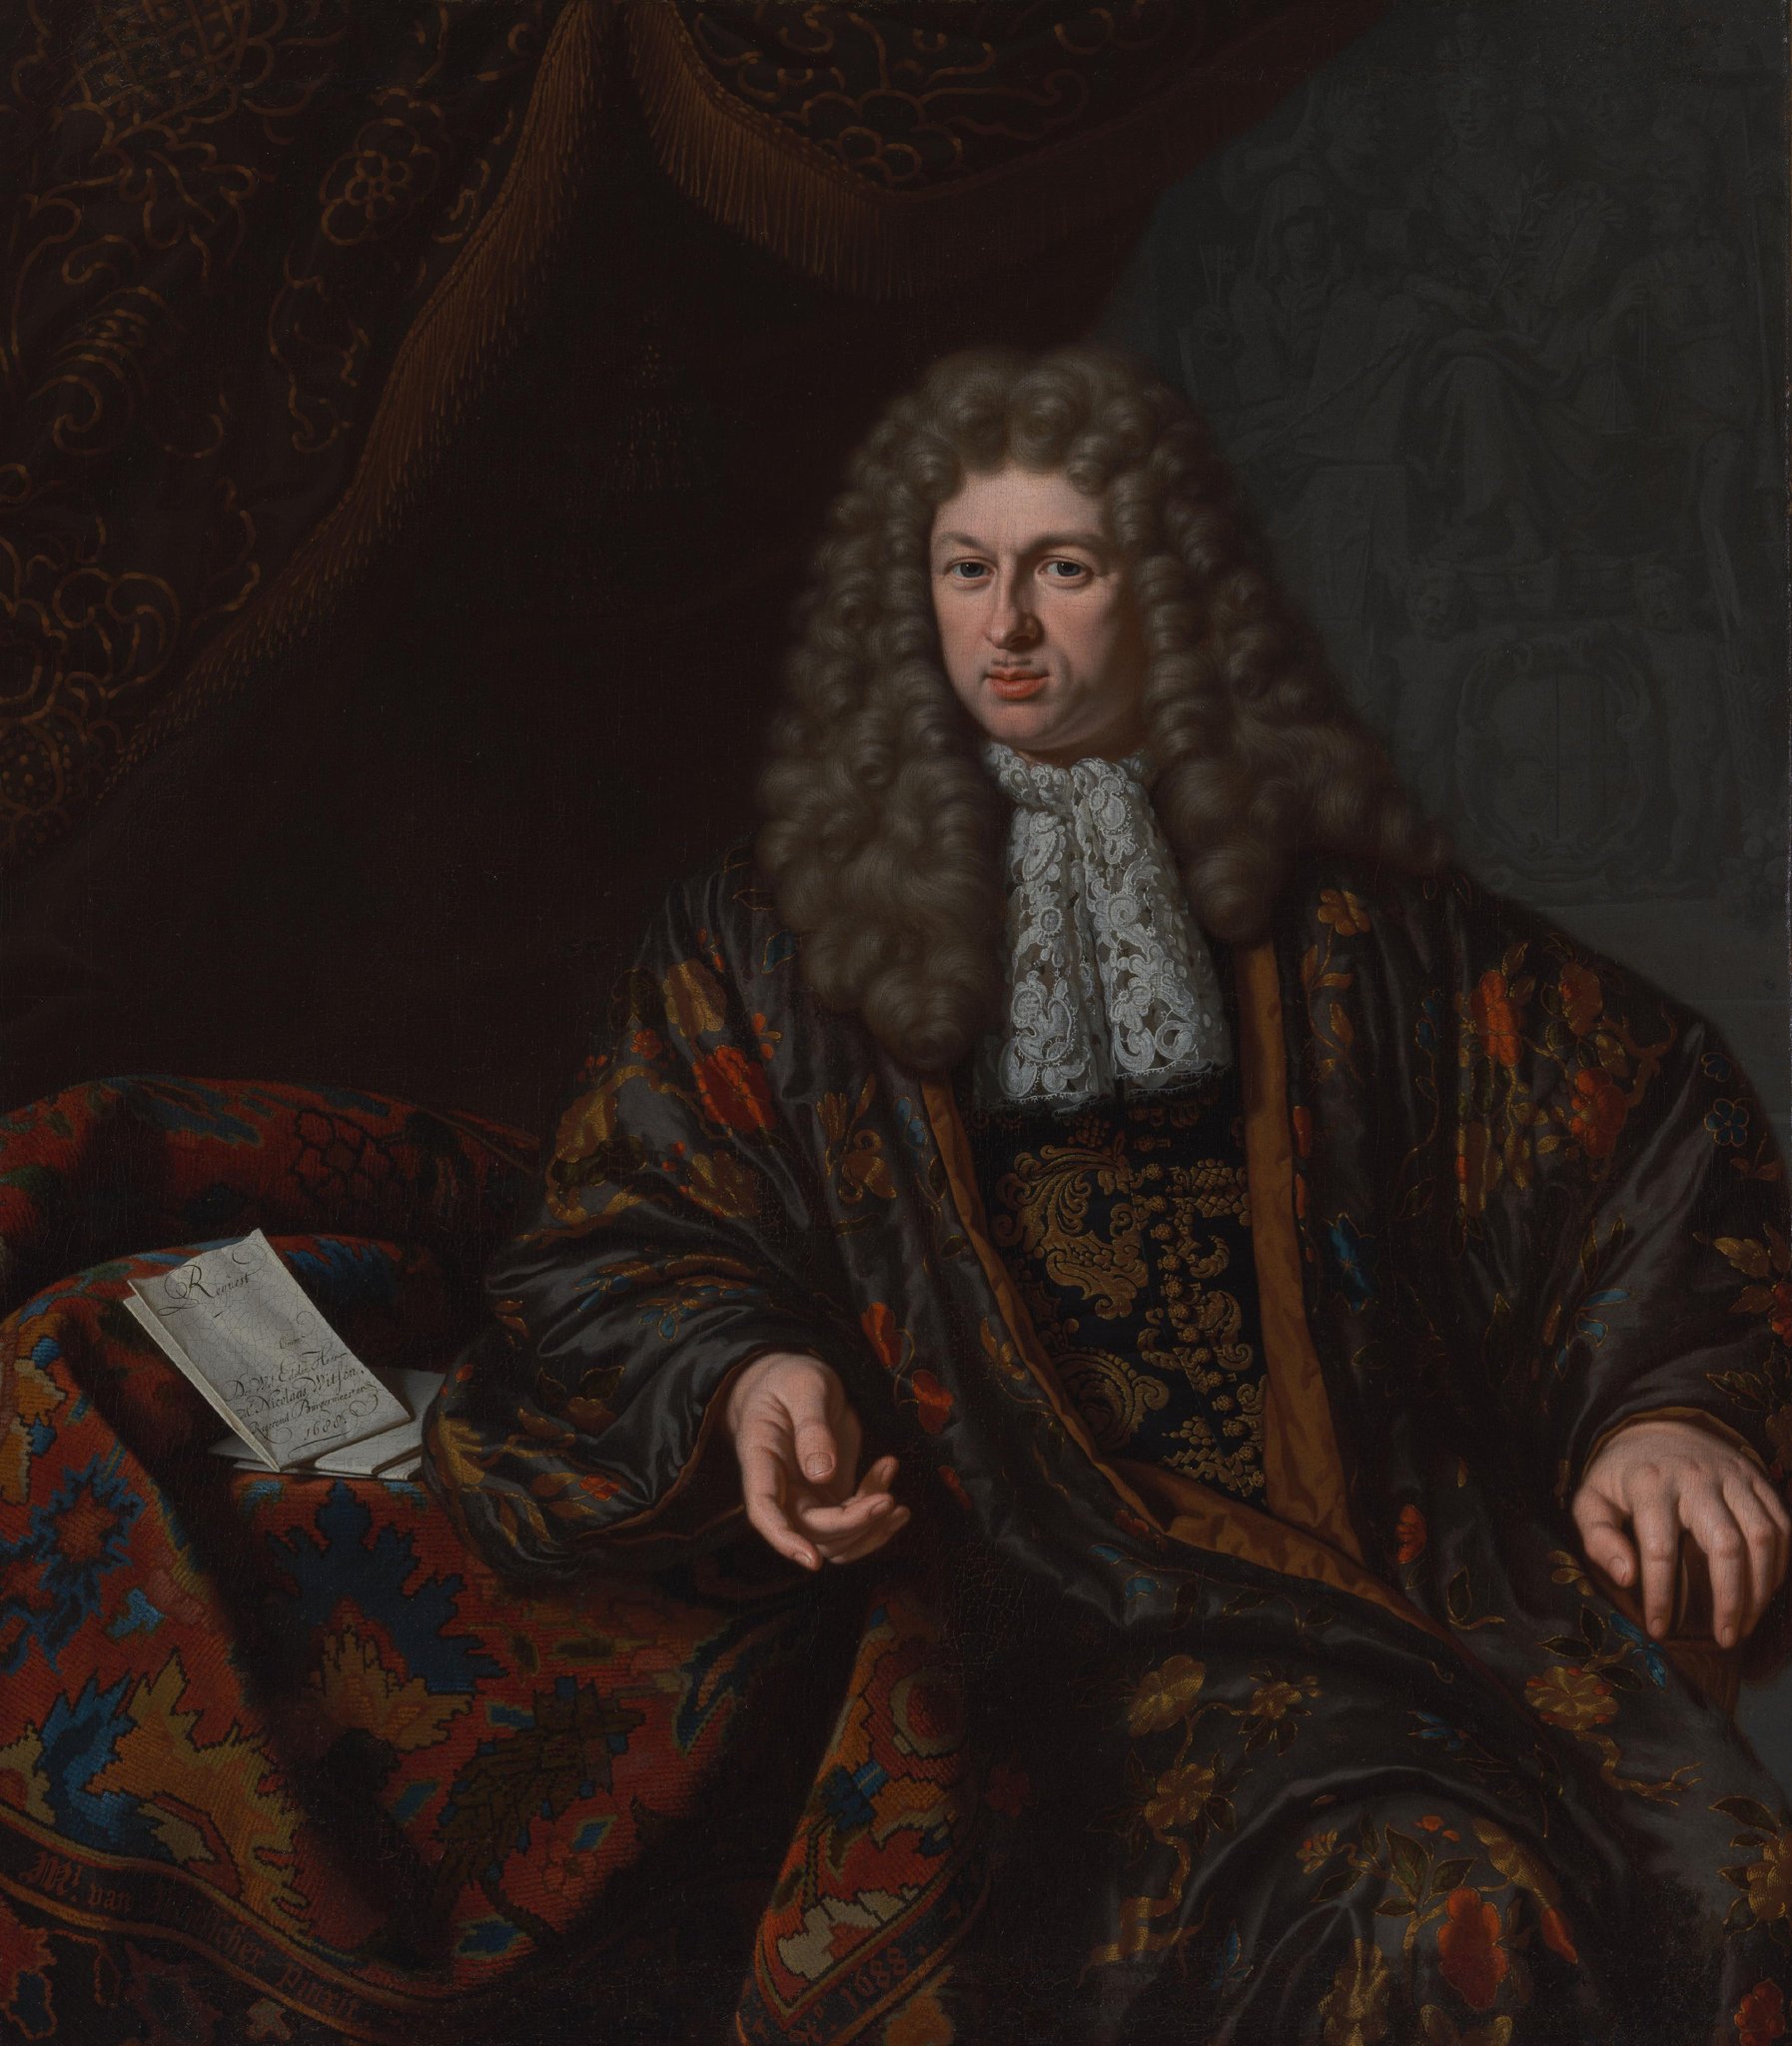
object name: painting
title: Portret van Nicolaes Witsen (1641-1717)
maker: michiel van musscher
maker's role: draughtsman, painter, print maker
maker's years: 1645-1705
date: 1688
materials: canvas, oil, paint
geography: amsterdam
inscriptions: inscription: ‘Request / Ommen / Den Wel Edelen Heer / Mr. Nicolaas Witsen, / Regerend Bürgermeester / 1688’, date: ‘1688’, signature: ‘M! van .usscher …x(of c?)it’, inscription: ‘Ter goeder Gedachtenis / van sijn Weldoender En Beschermer / den Heer N. Witsen gaende in sijn / aght en veertigste Jaer wanneer hij voor / de derde mael deser stede Amsterdam / Burgermeester was / heft Thomas Heese / dese Schilderij laten maeken van / Michiel de Musscher’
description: Van Musscher toont Witsen als kniestuk, het hoofd naar links, zittend op een stoel, aanziend. Gekleed in een Japonsche rock, met een lange pruik, maakt hij met zijn rechter hand een sprekend gebaar. Op tafel een oosters tafelkleed en een brief, rechts op de achtergrond een reliëf met een allegorische voorstelling van Amsterdam.